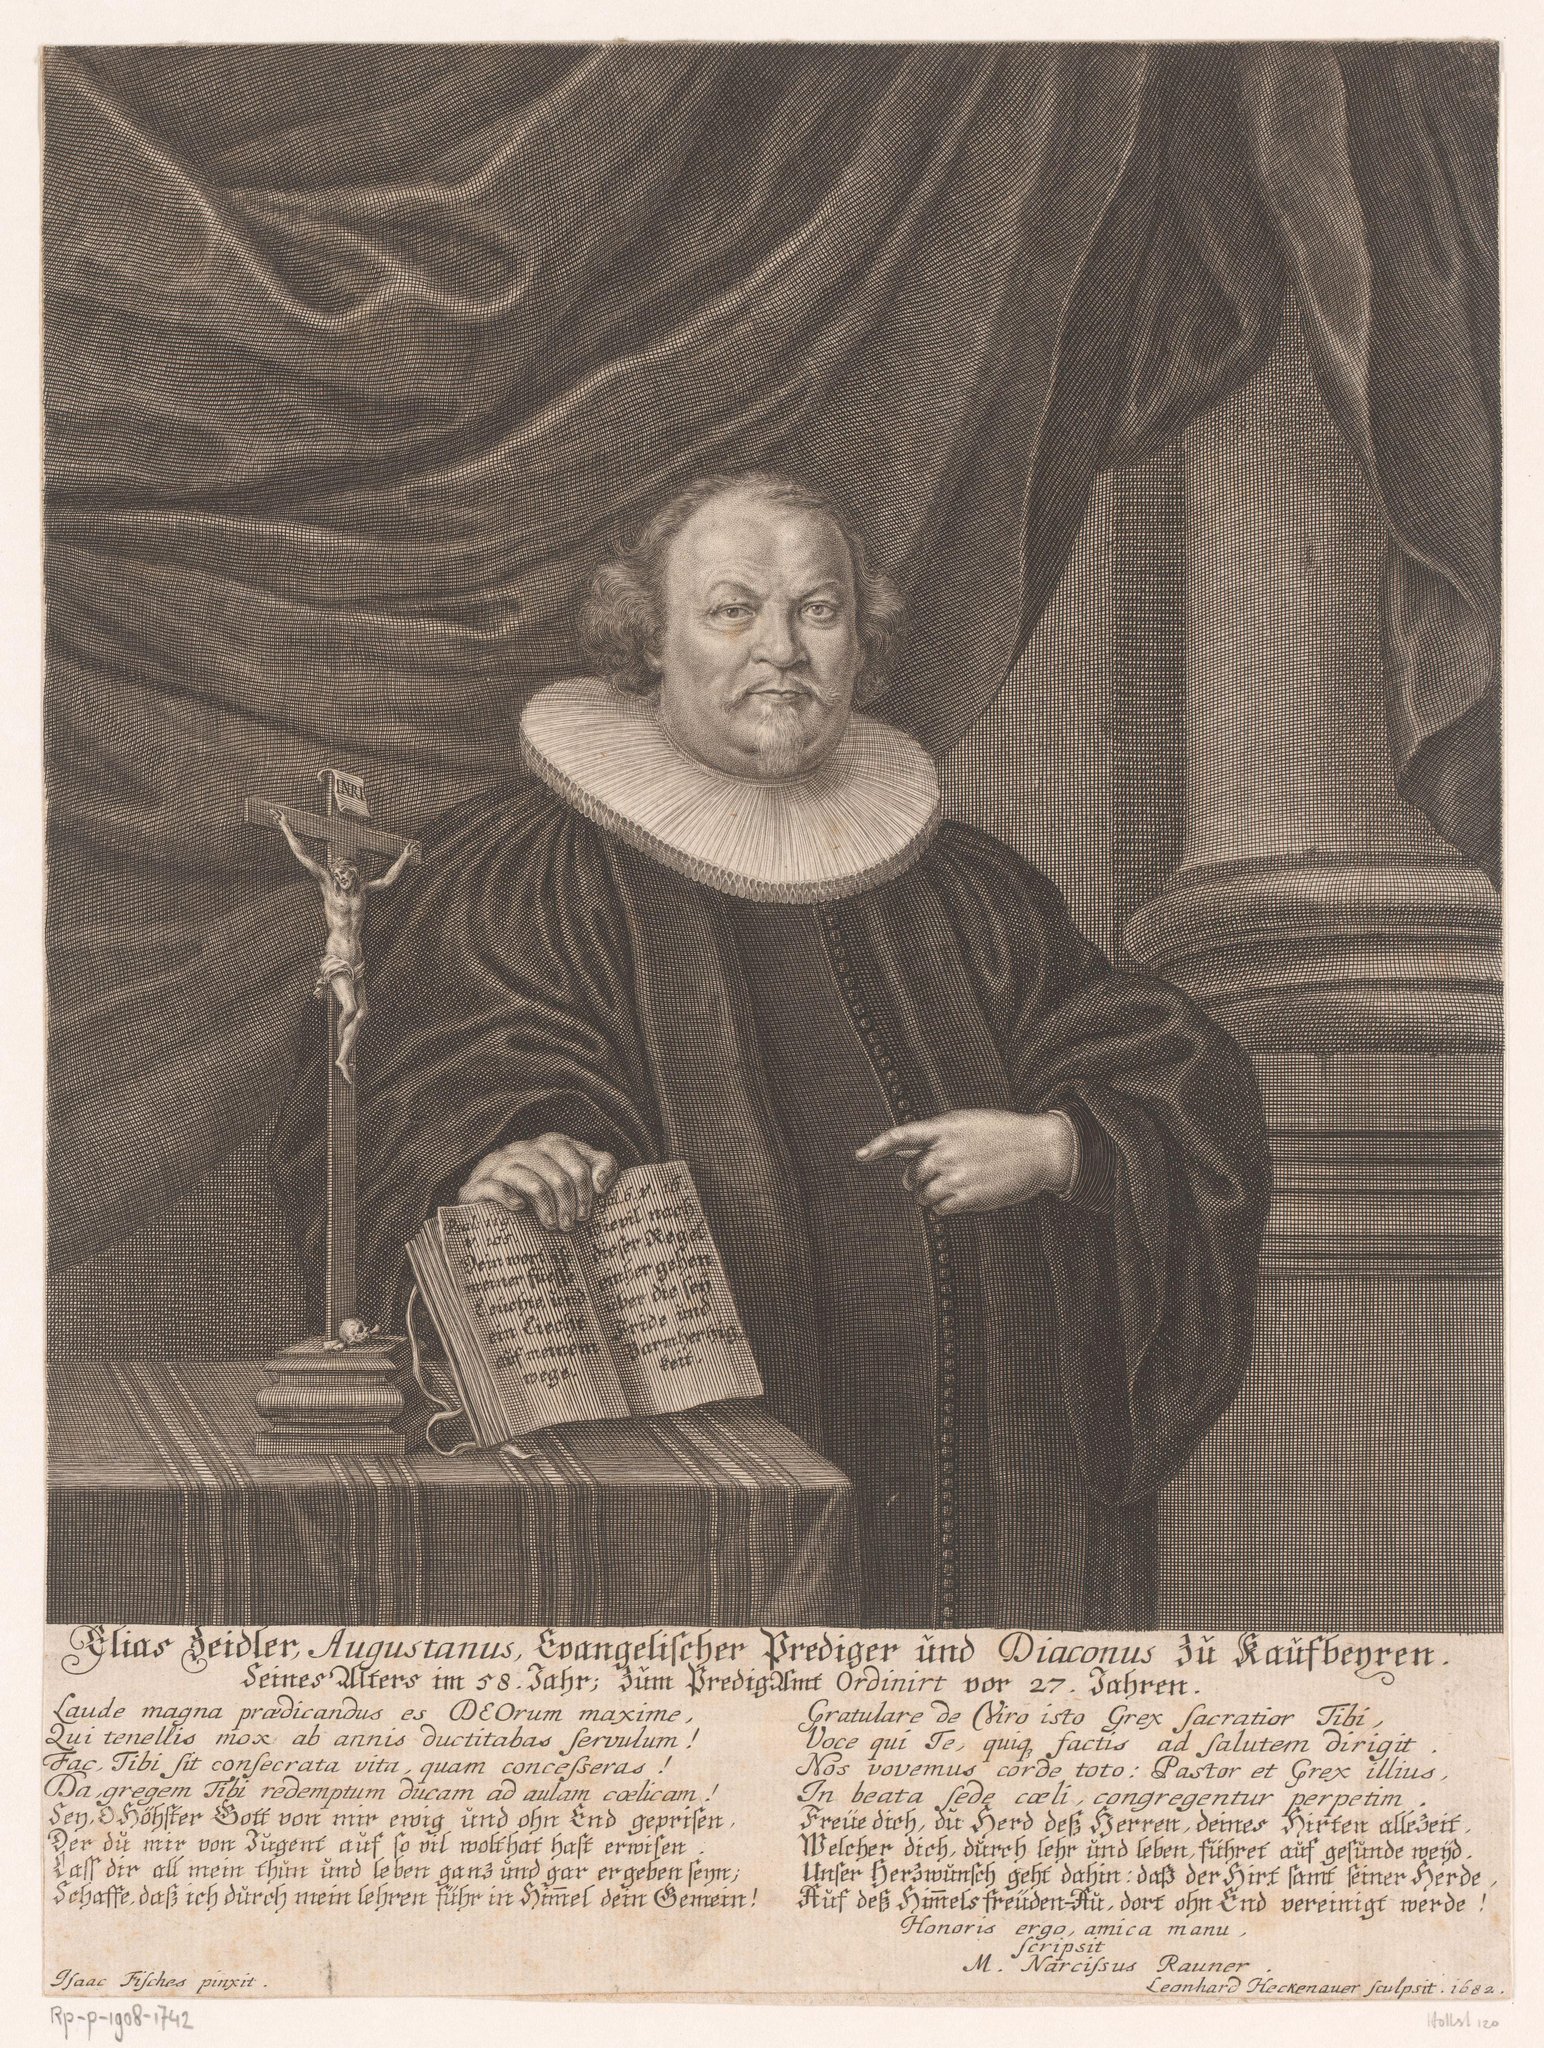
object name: print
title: Portret van Anton Schöner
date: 1690-1704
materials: paper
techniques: engraving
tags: historical persons, ornament ~ festoon, garland, watch, cupids: 'amores', 'amoretti', 'putti', armorial bearing, heraldry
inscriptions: collector's mark: Lugt 2228